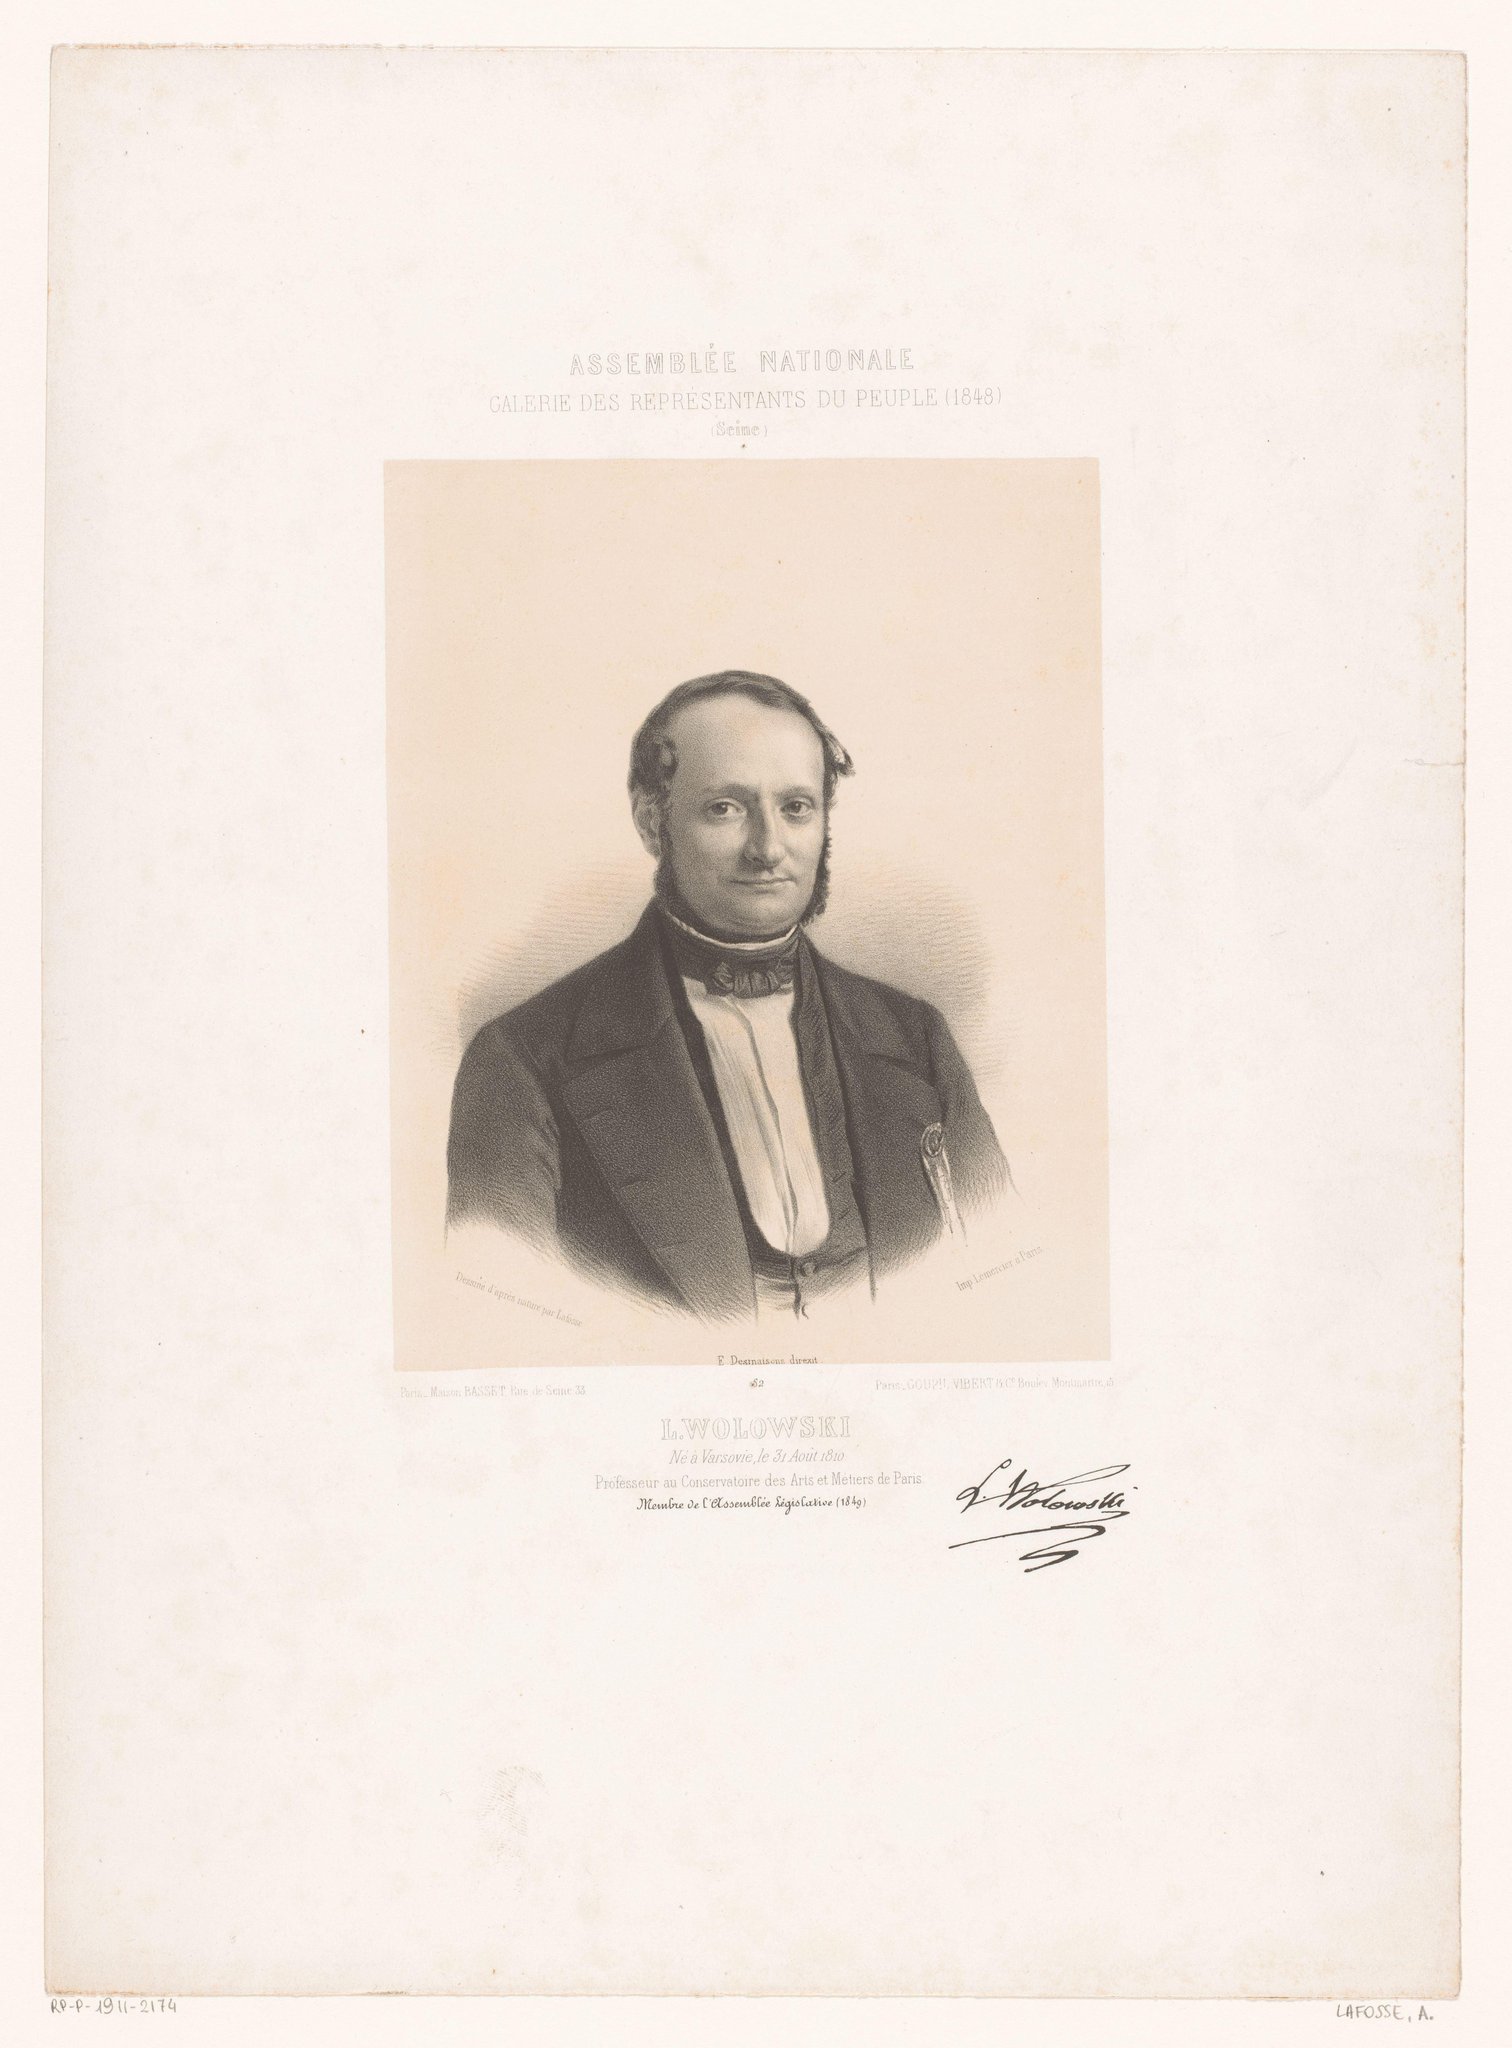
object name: print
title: L. Wolowski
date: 1848-1849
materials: paper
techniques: tone lithography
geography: paris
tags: politician, historical persons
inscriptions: collector's mark: Lugt 2228a